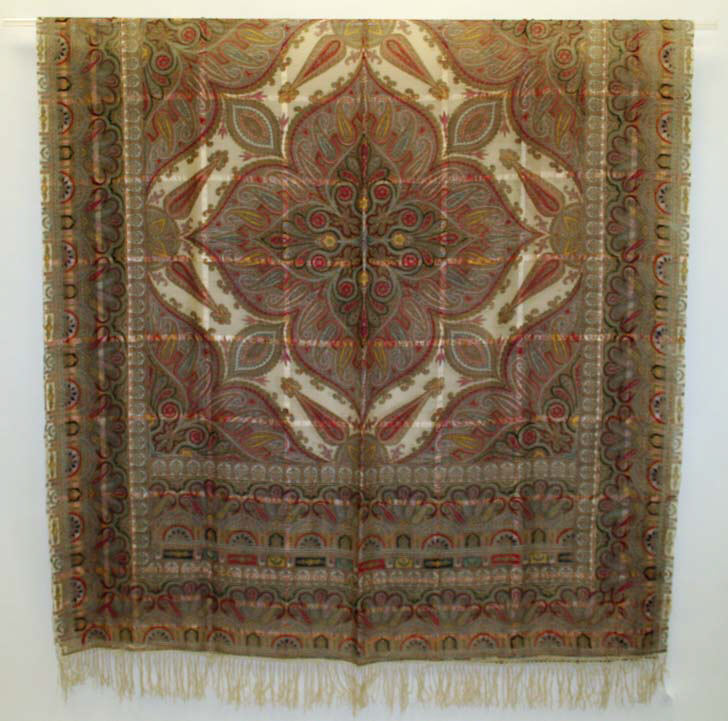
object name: shawl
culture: french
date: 1850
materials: wool